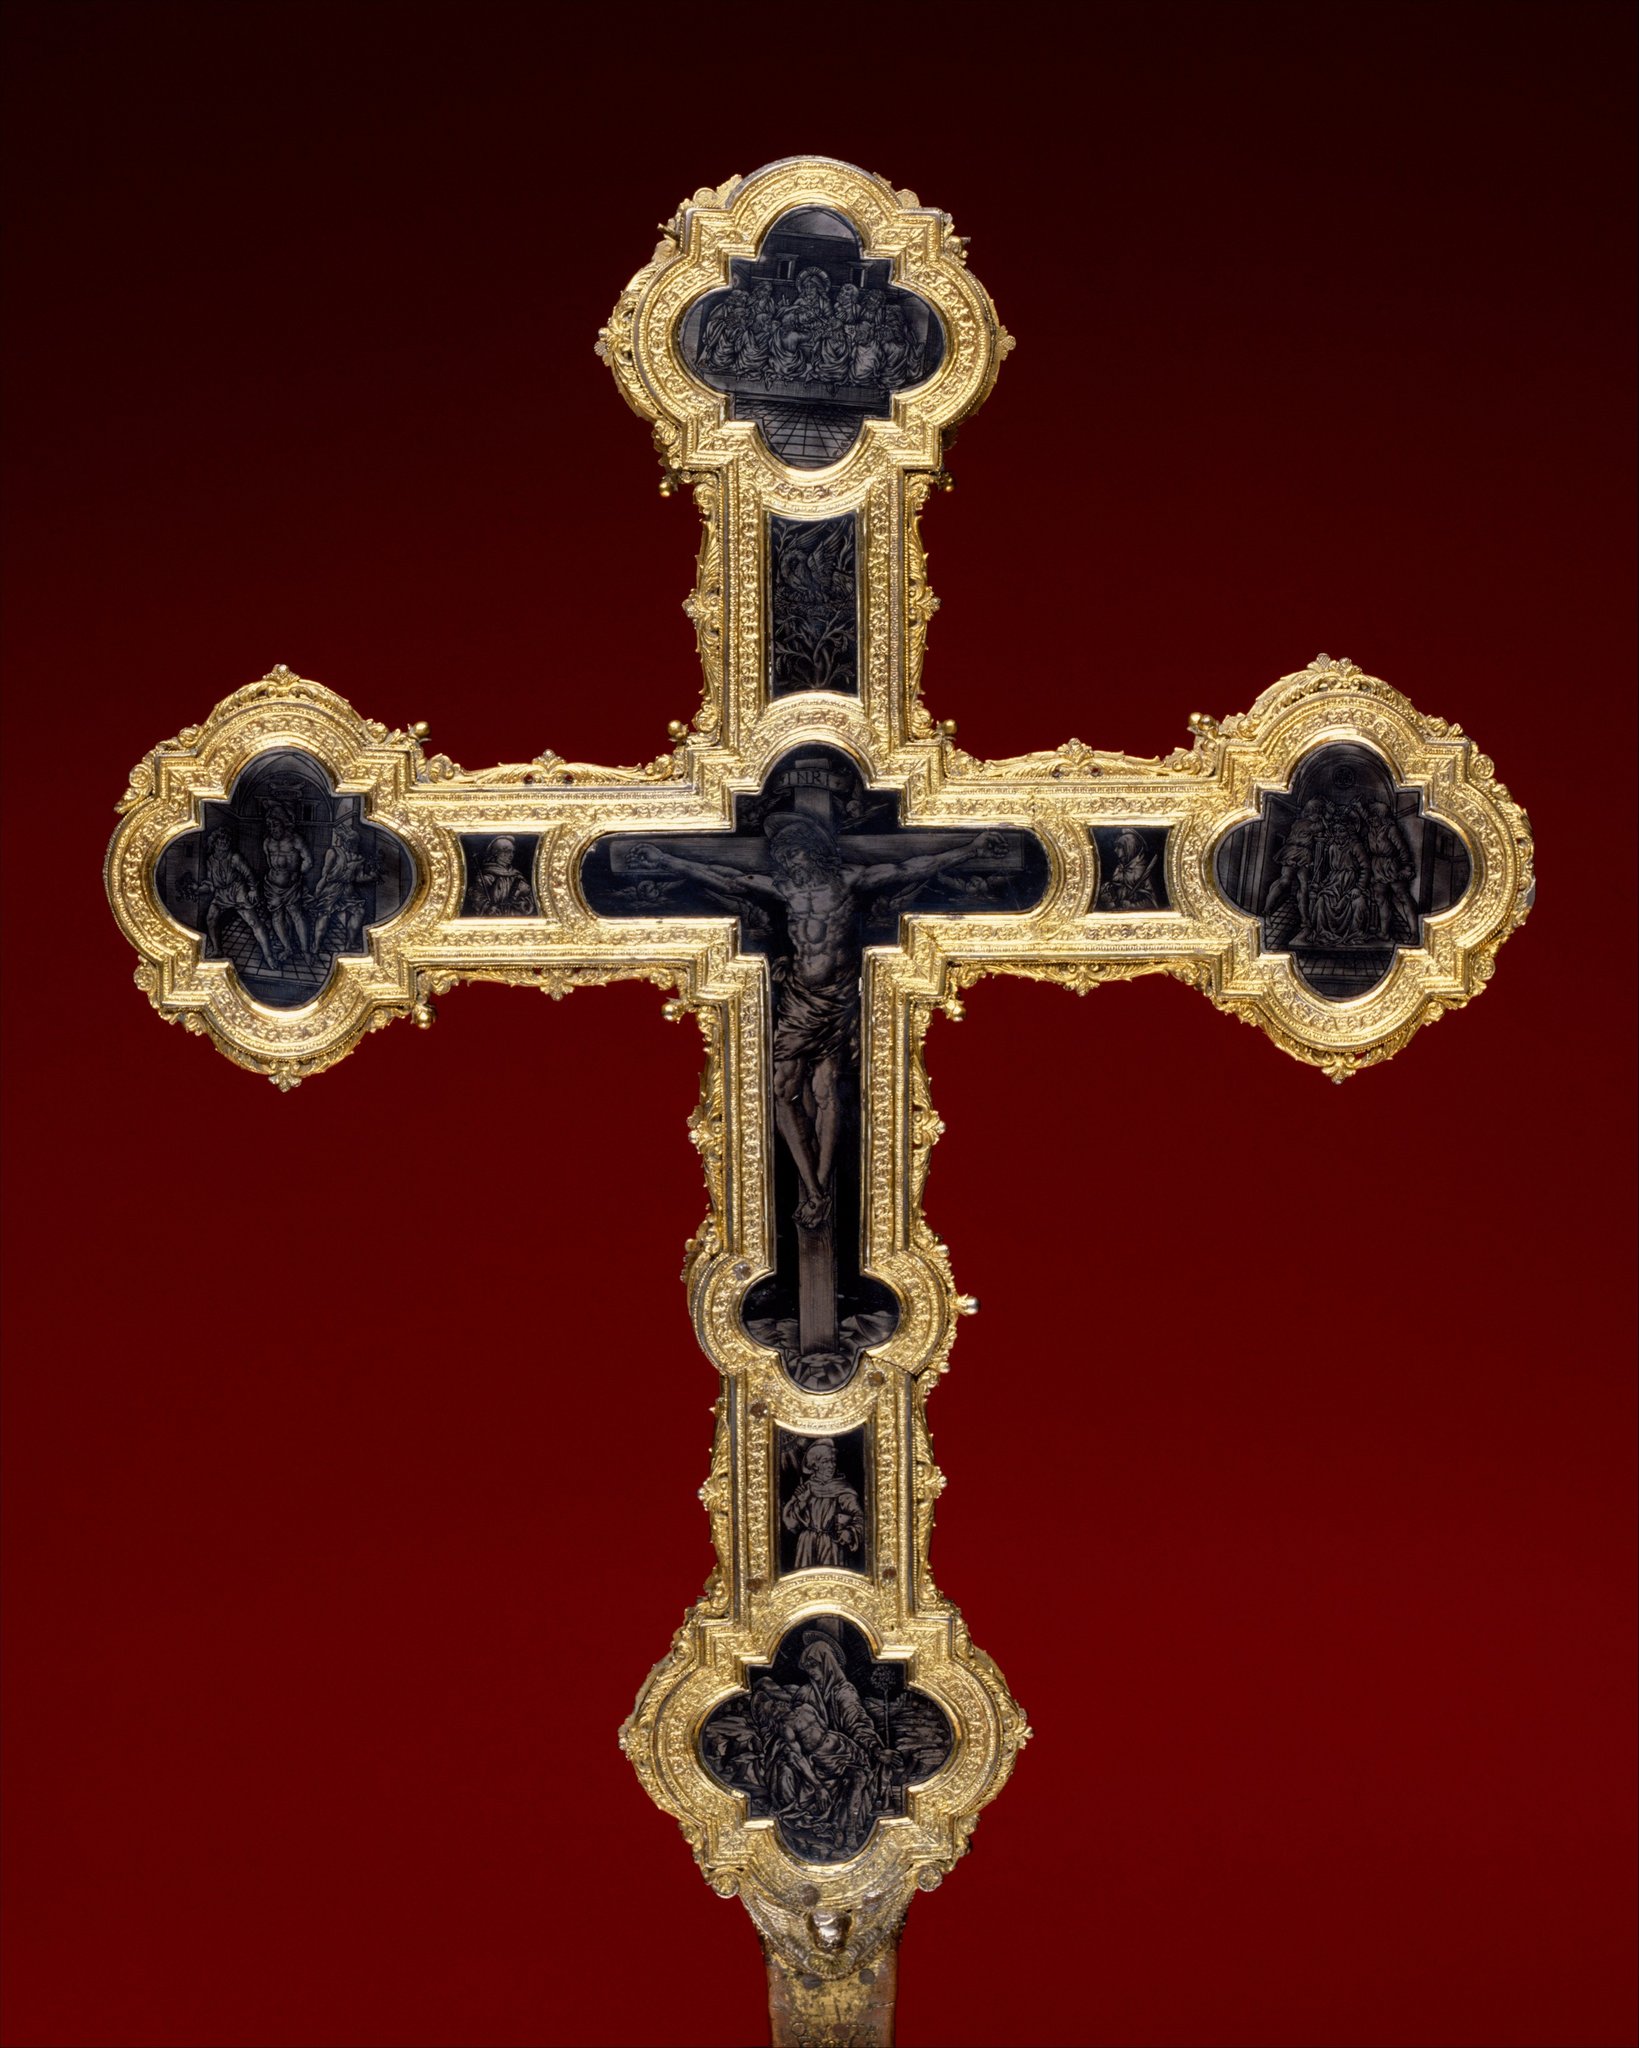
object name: processional cross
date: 1460-1480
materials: copper, silver gilt, niello, wood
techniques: gilding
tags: christ,cross,crucifixion,last supper,saints